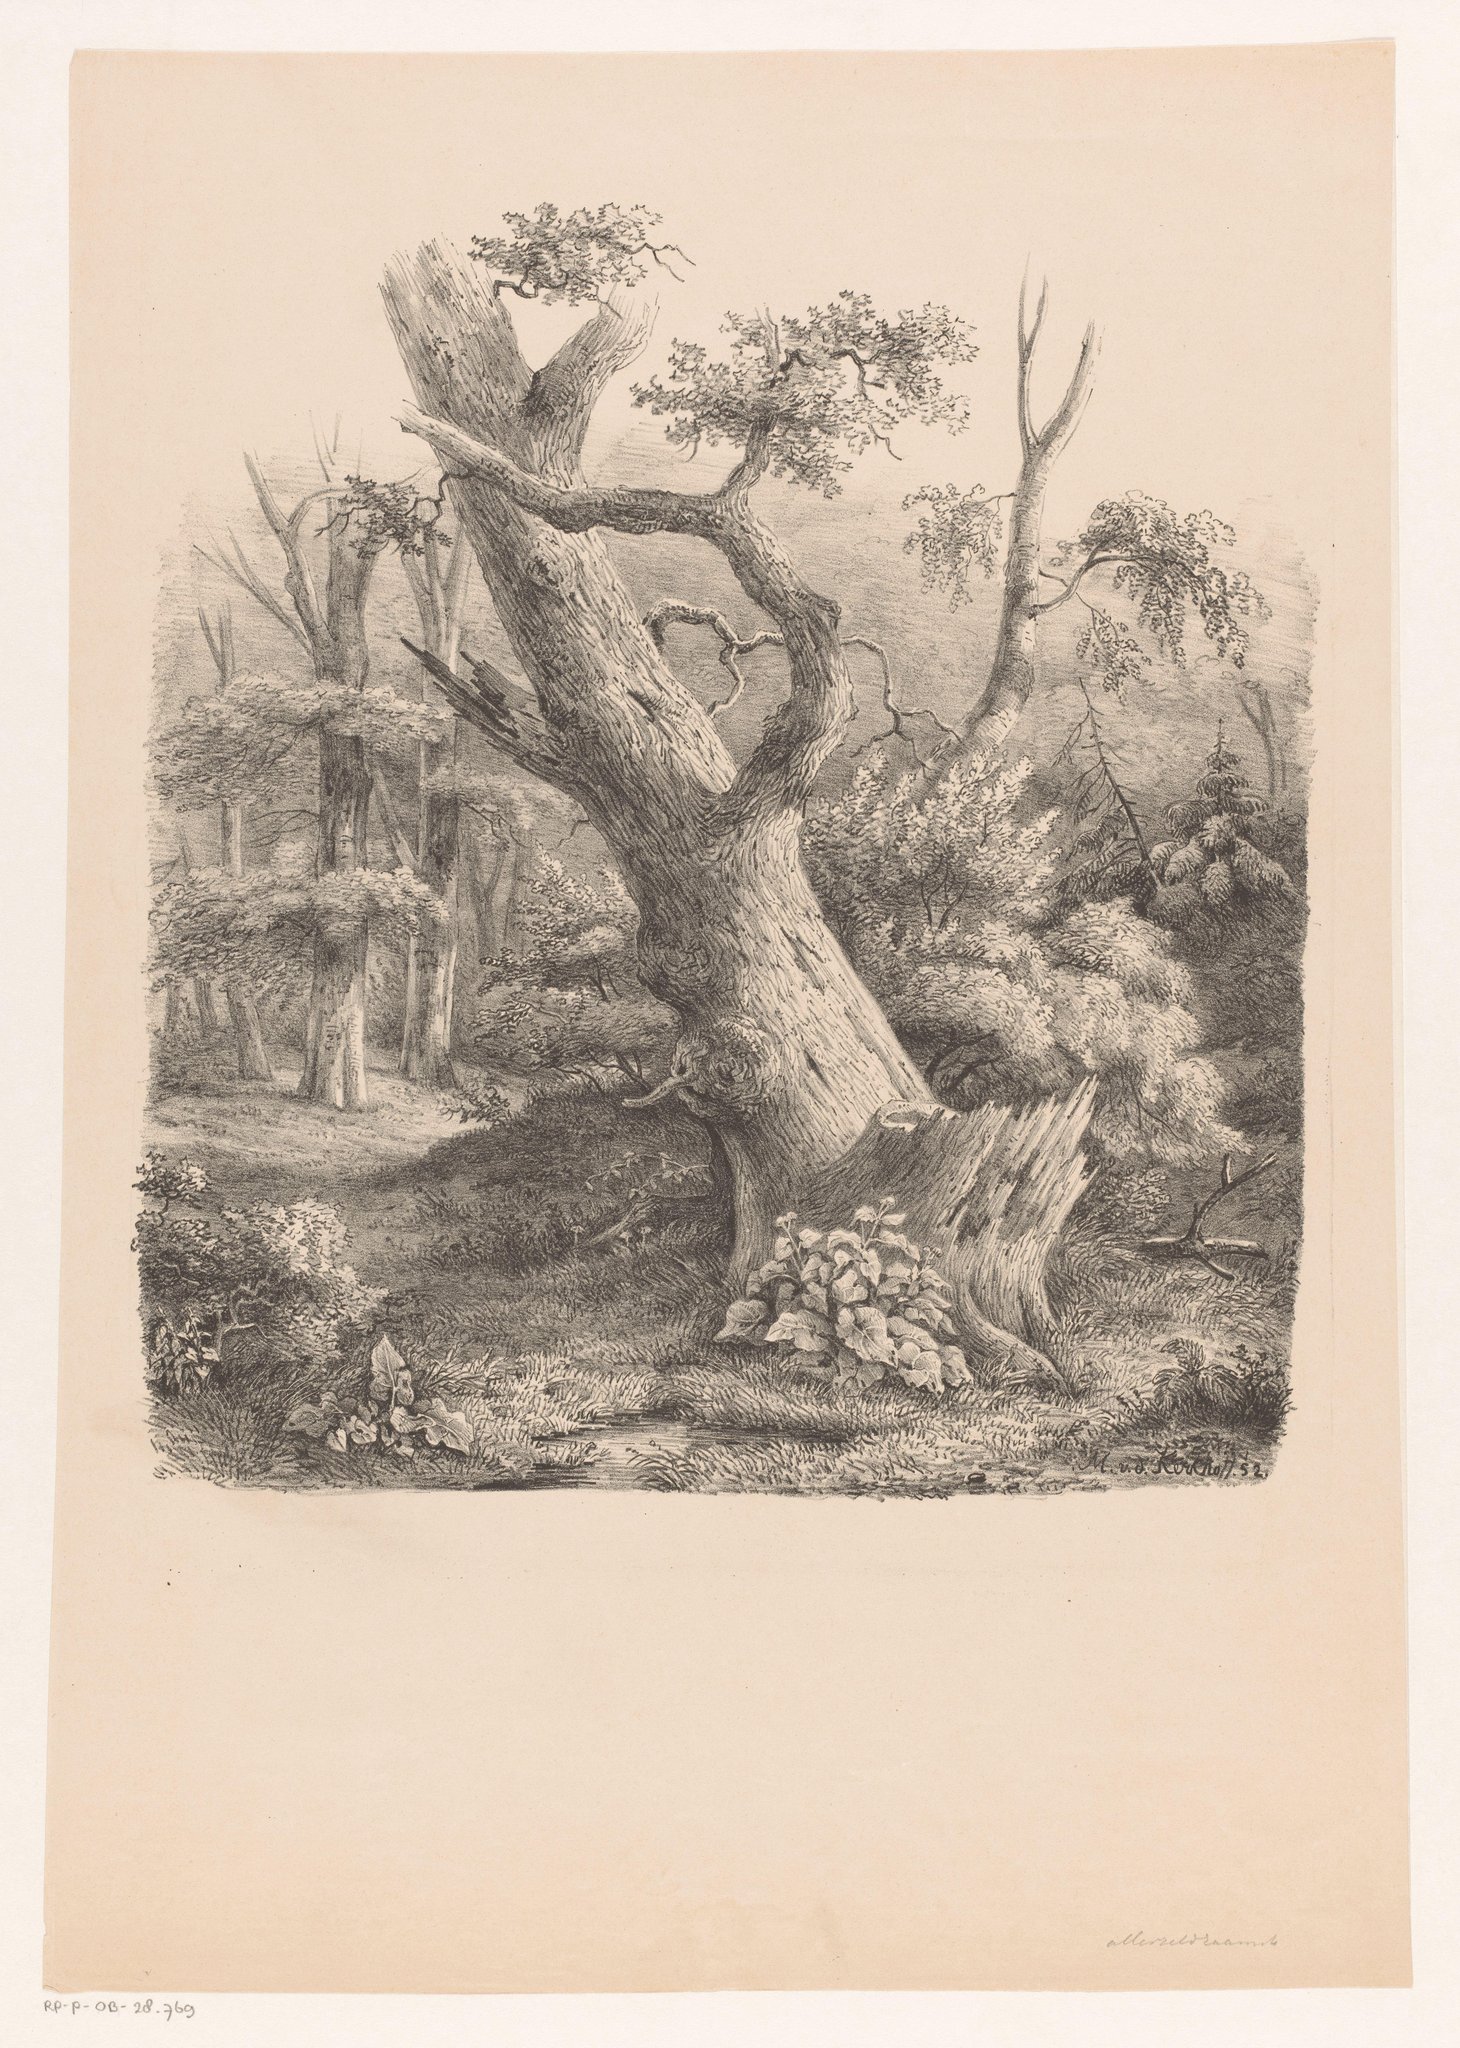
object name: print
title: Schuine boom in het bos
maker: maurits e.h.r. van den kerkhoff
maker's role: painter, print maker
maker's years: 1830-1908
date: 1852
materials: paper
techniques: lithograph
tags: trees, forest, wood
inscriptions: inscription: ‘allerzeldzaamst’, collector's mark: Lugt 2228